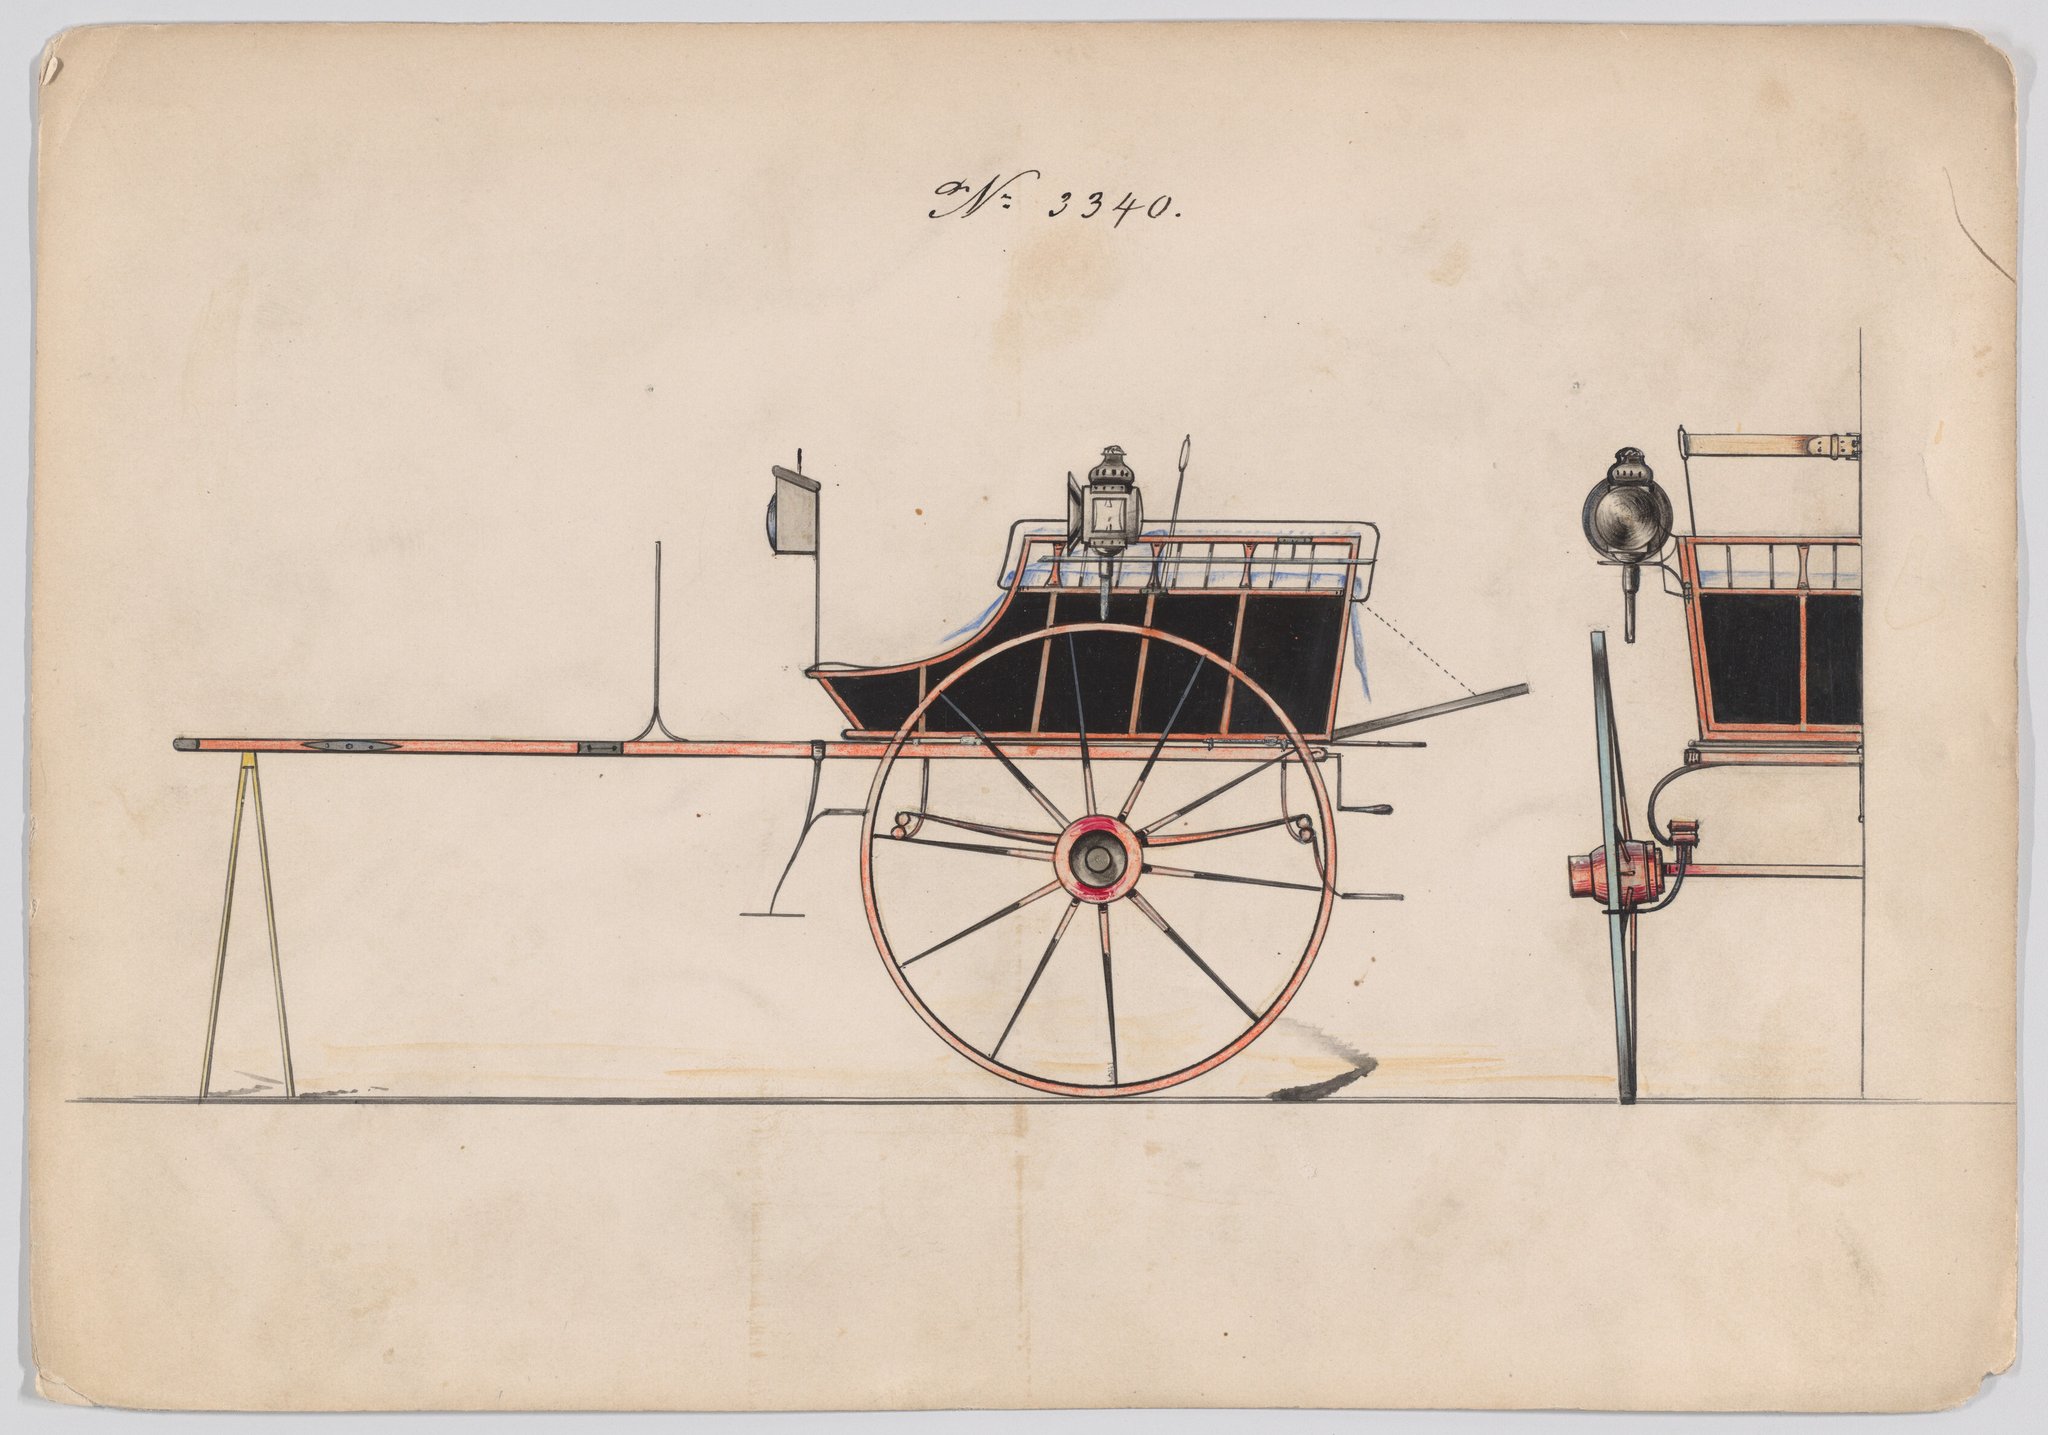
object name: drawing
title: White Chapel Cart # 3340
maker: brewster & co.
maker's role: manufacturer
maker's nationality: american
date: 1877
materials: gouache, gum arabic, ink, watercolor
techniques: pen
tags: carriages